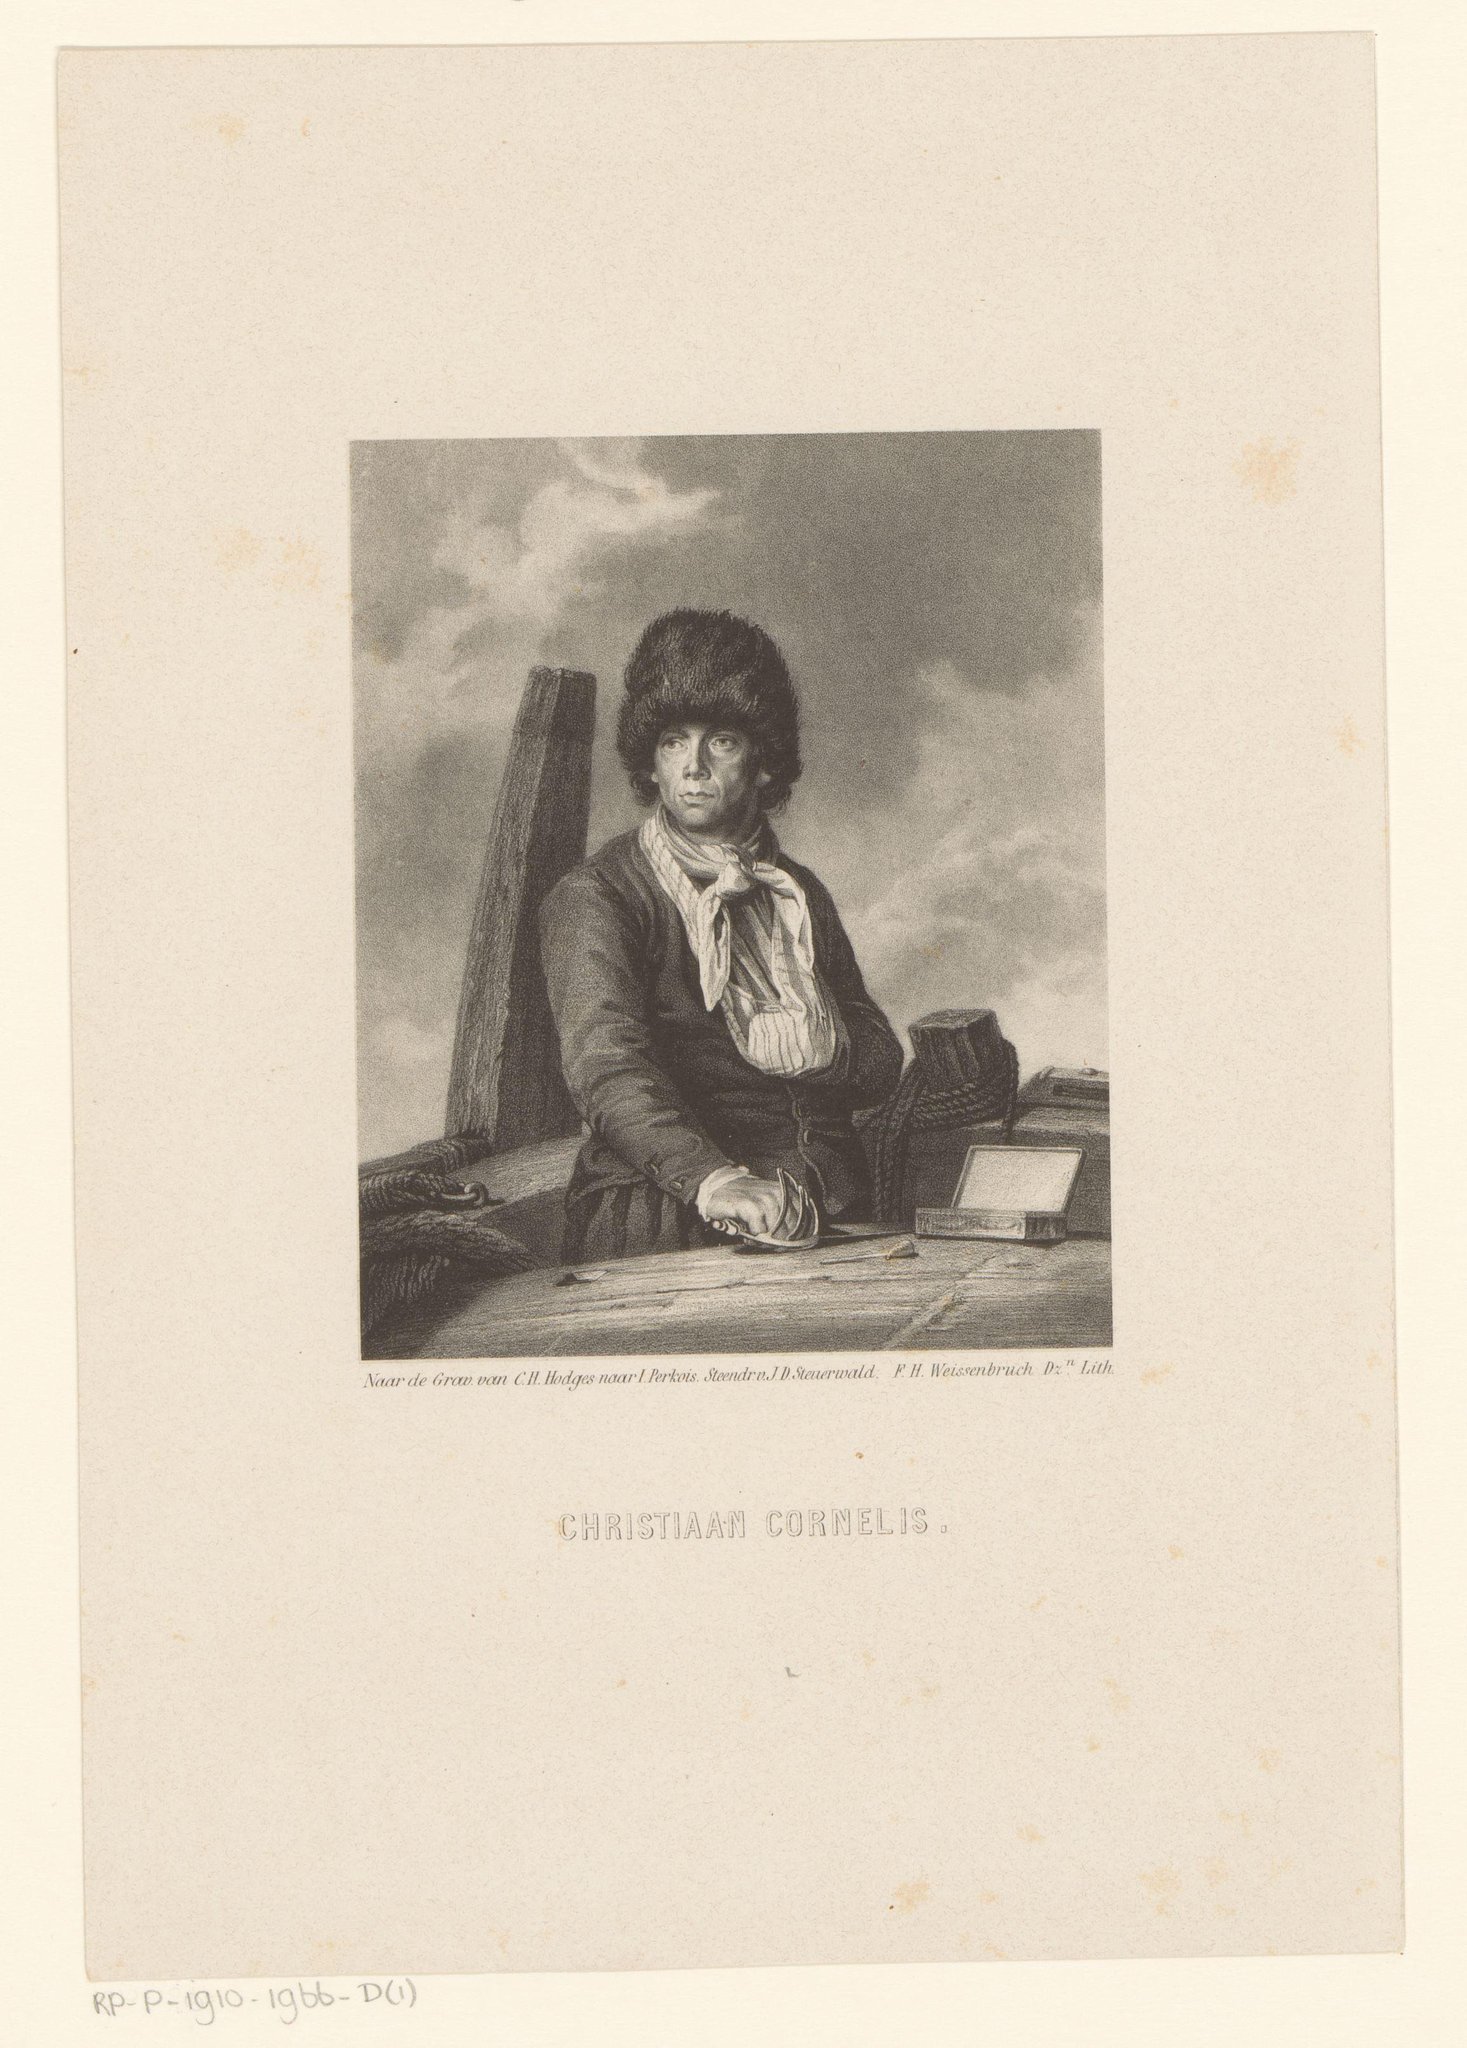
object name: print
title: Portret van Christiaan Cornelis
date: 1858-1862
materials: paper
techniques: lithograph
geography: the hague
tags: historical persons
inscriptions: collector's mark: Lugt 2228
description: Prent uit: Jonge, J.C. de. Geschiedenis van het Nederlandsche zeewezen. Haarlem: Jonge, J.K.J. de, 1858-62.